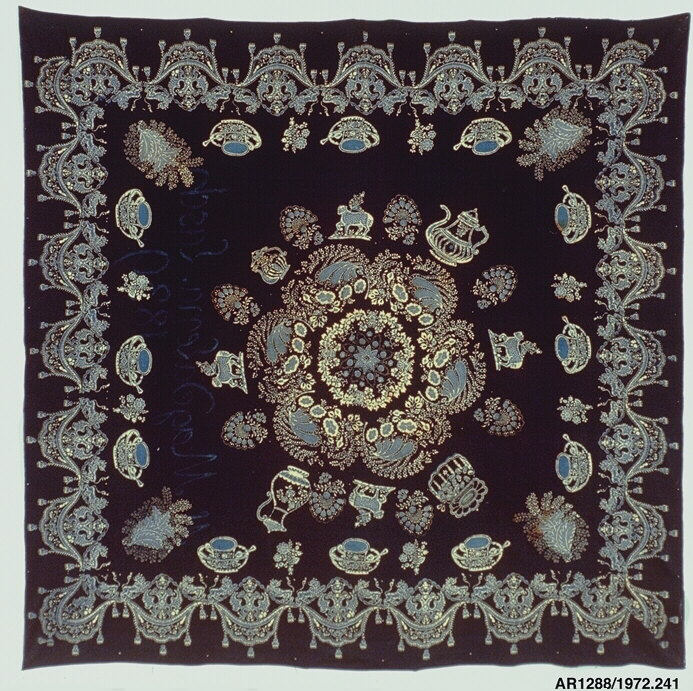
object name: tablecloth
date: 1839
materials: cotton